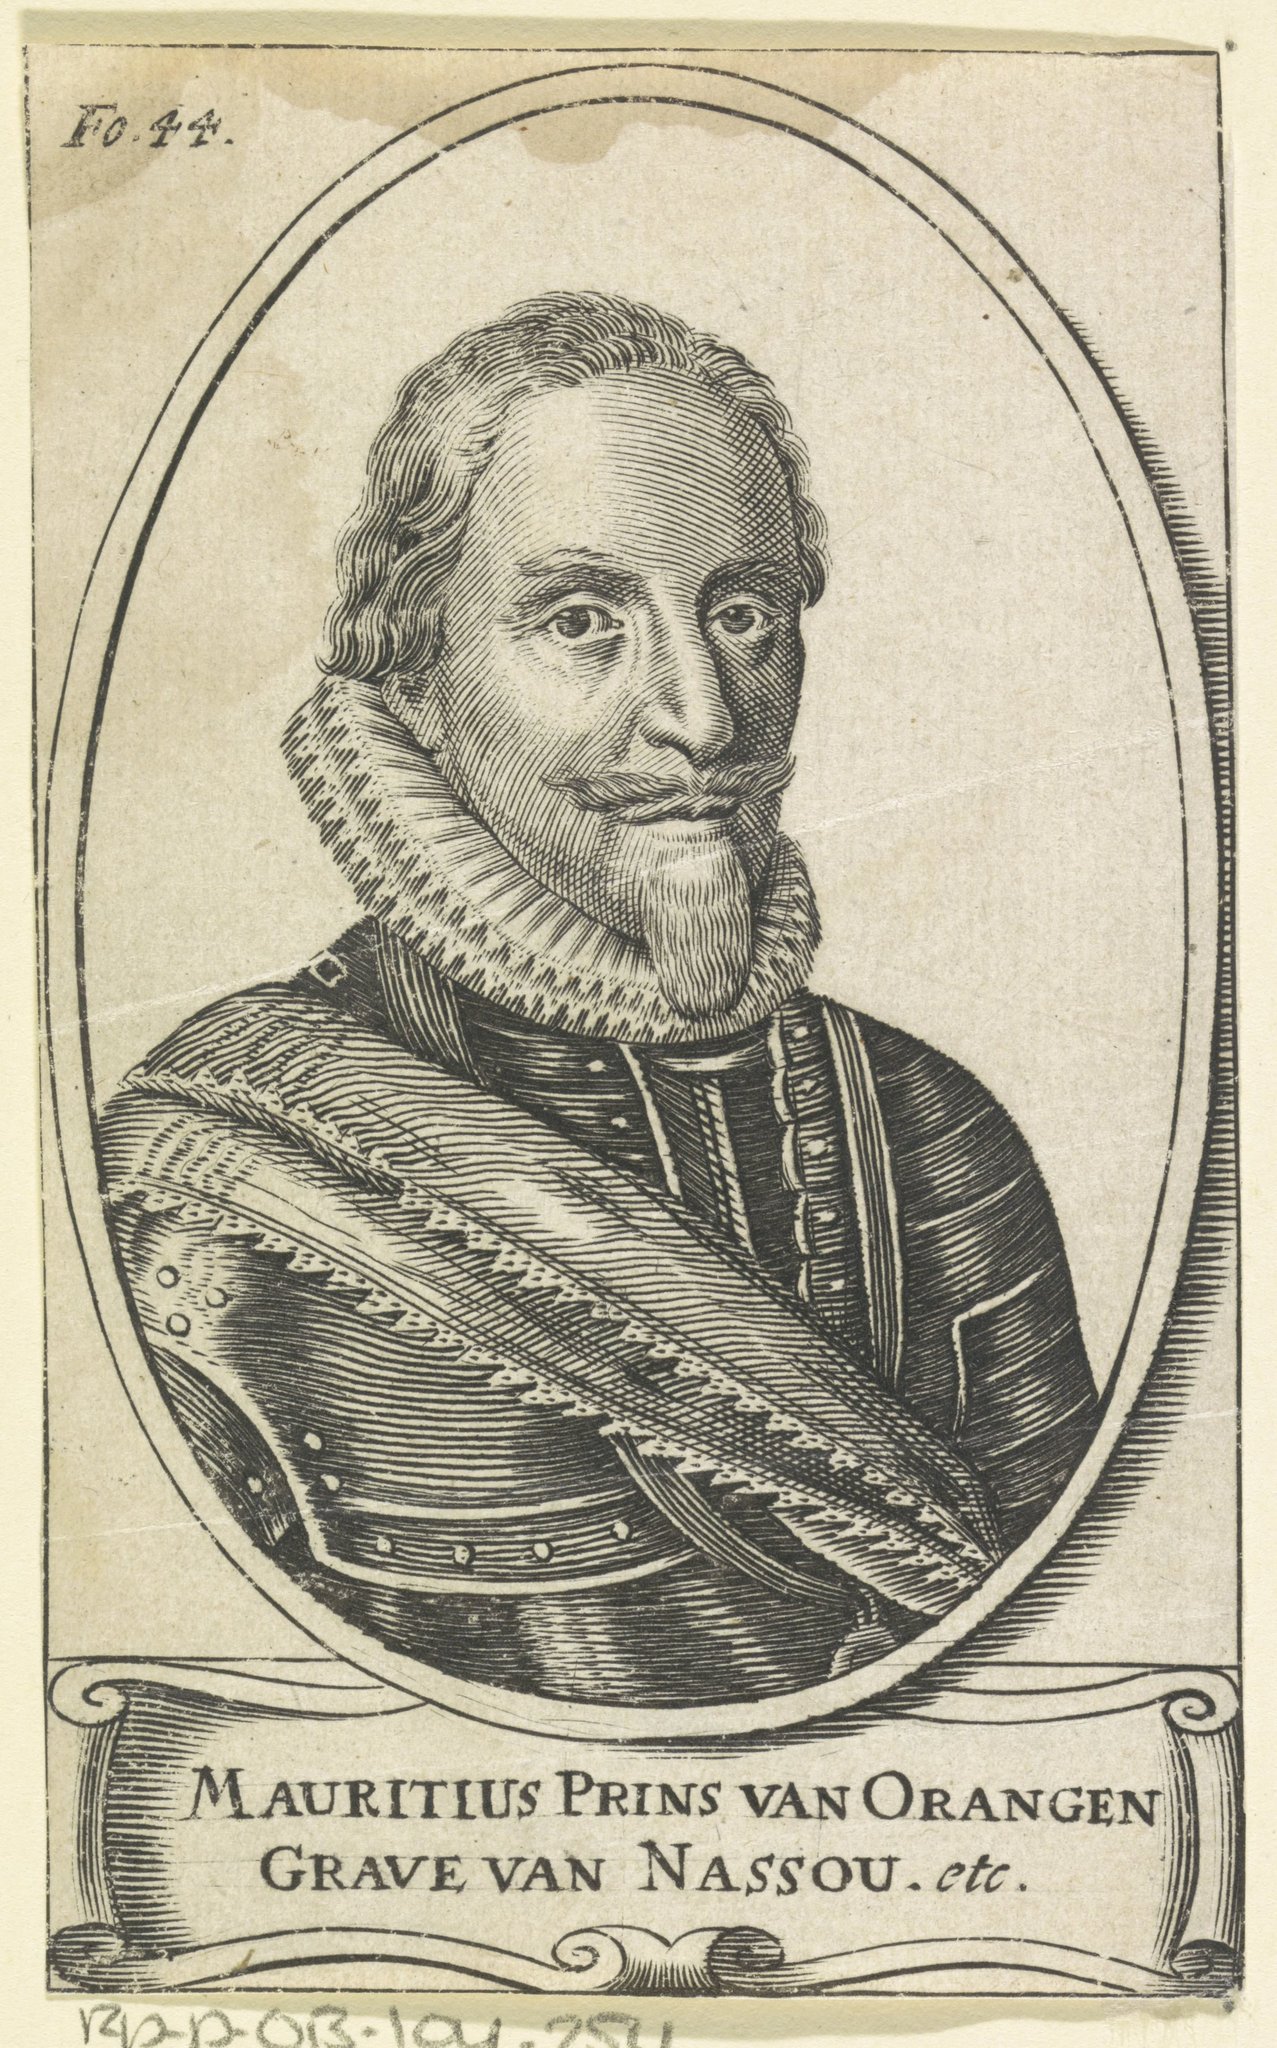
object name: print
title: Portret van Maurits, prins van Oranje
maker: Anonymous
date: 1600-1699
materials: paper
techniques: engraving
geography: low countries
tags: the hague, maurice (prince of orange), knighthood order (garter) - insignia of a knighthood order, e.g.: badge, chain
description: De hier vermelde titel verwijst naar de hoogst verkregen titel van de geportretteerde, niet per se naar de titel die de geportretteerde op deze voorstelling draagt.